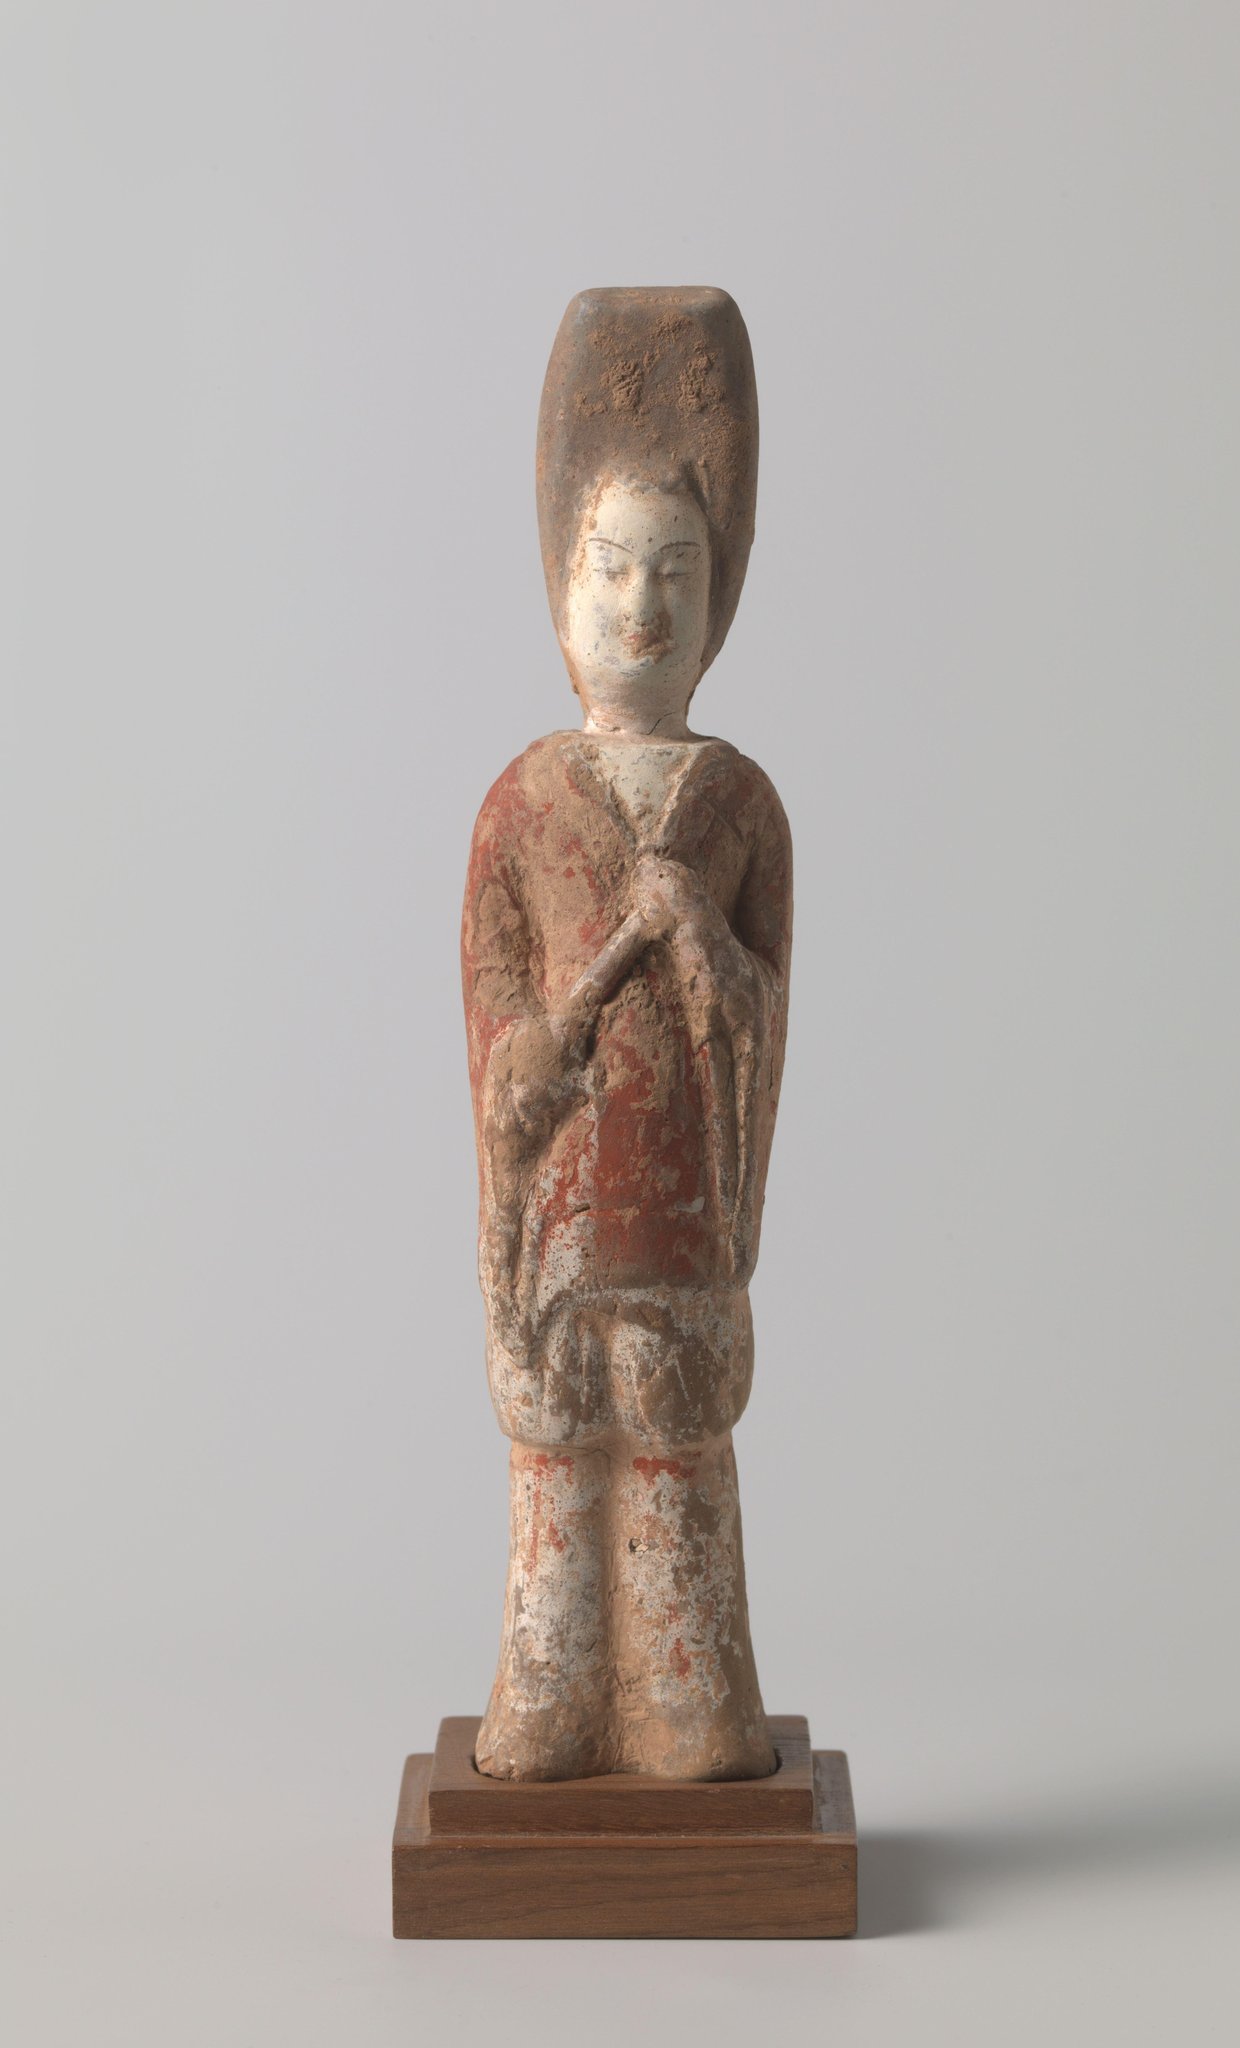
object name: tomb figure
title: Funeral figure in the shape of a woman with a flute[?]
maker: Anonymous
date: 220-589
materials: earthenware, paint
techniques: forming, turning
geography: china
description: Staande graffiguur, musicienne, op een los houten voetstuk. De figuur is gekleed in een rood gewaad met V-hals en wijde mouwen en heeft een hoog opgewerkt kapsel. De beschildering is in rood, zwart en wit. Zij houdt een fluit(?) in de hand.